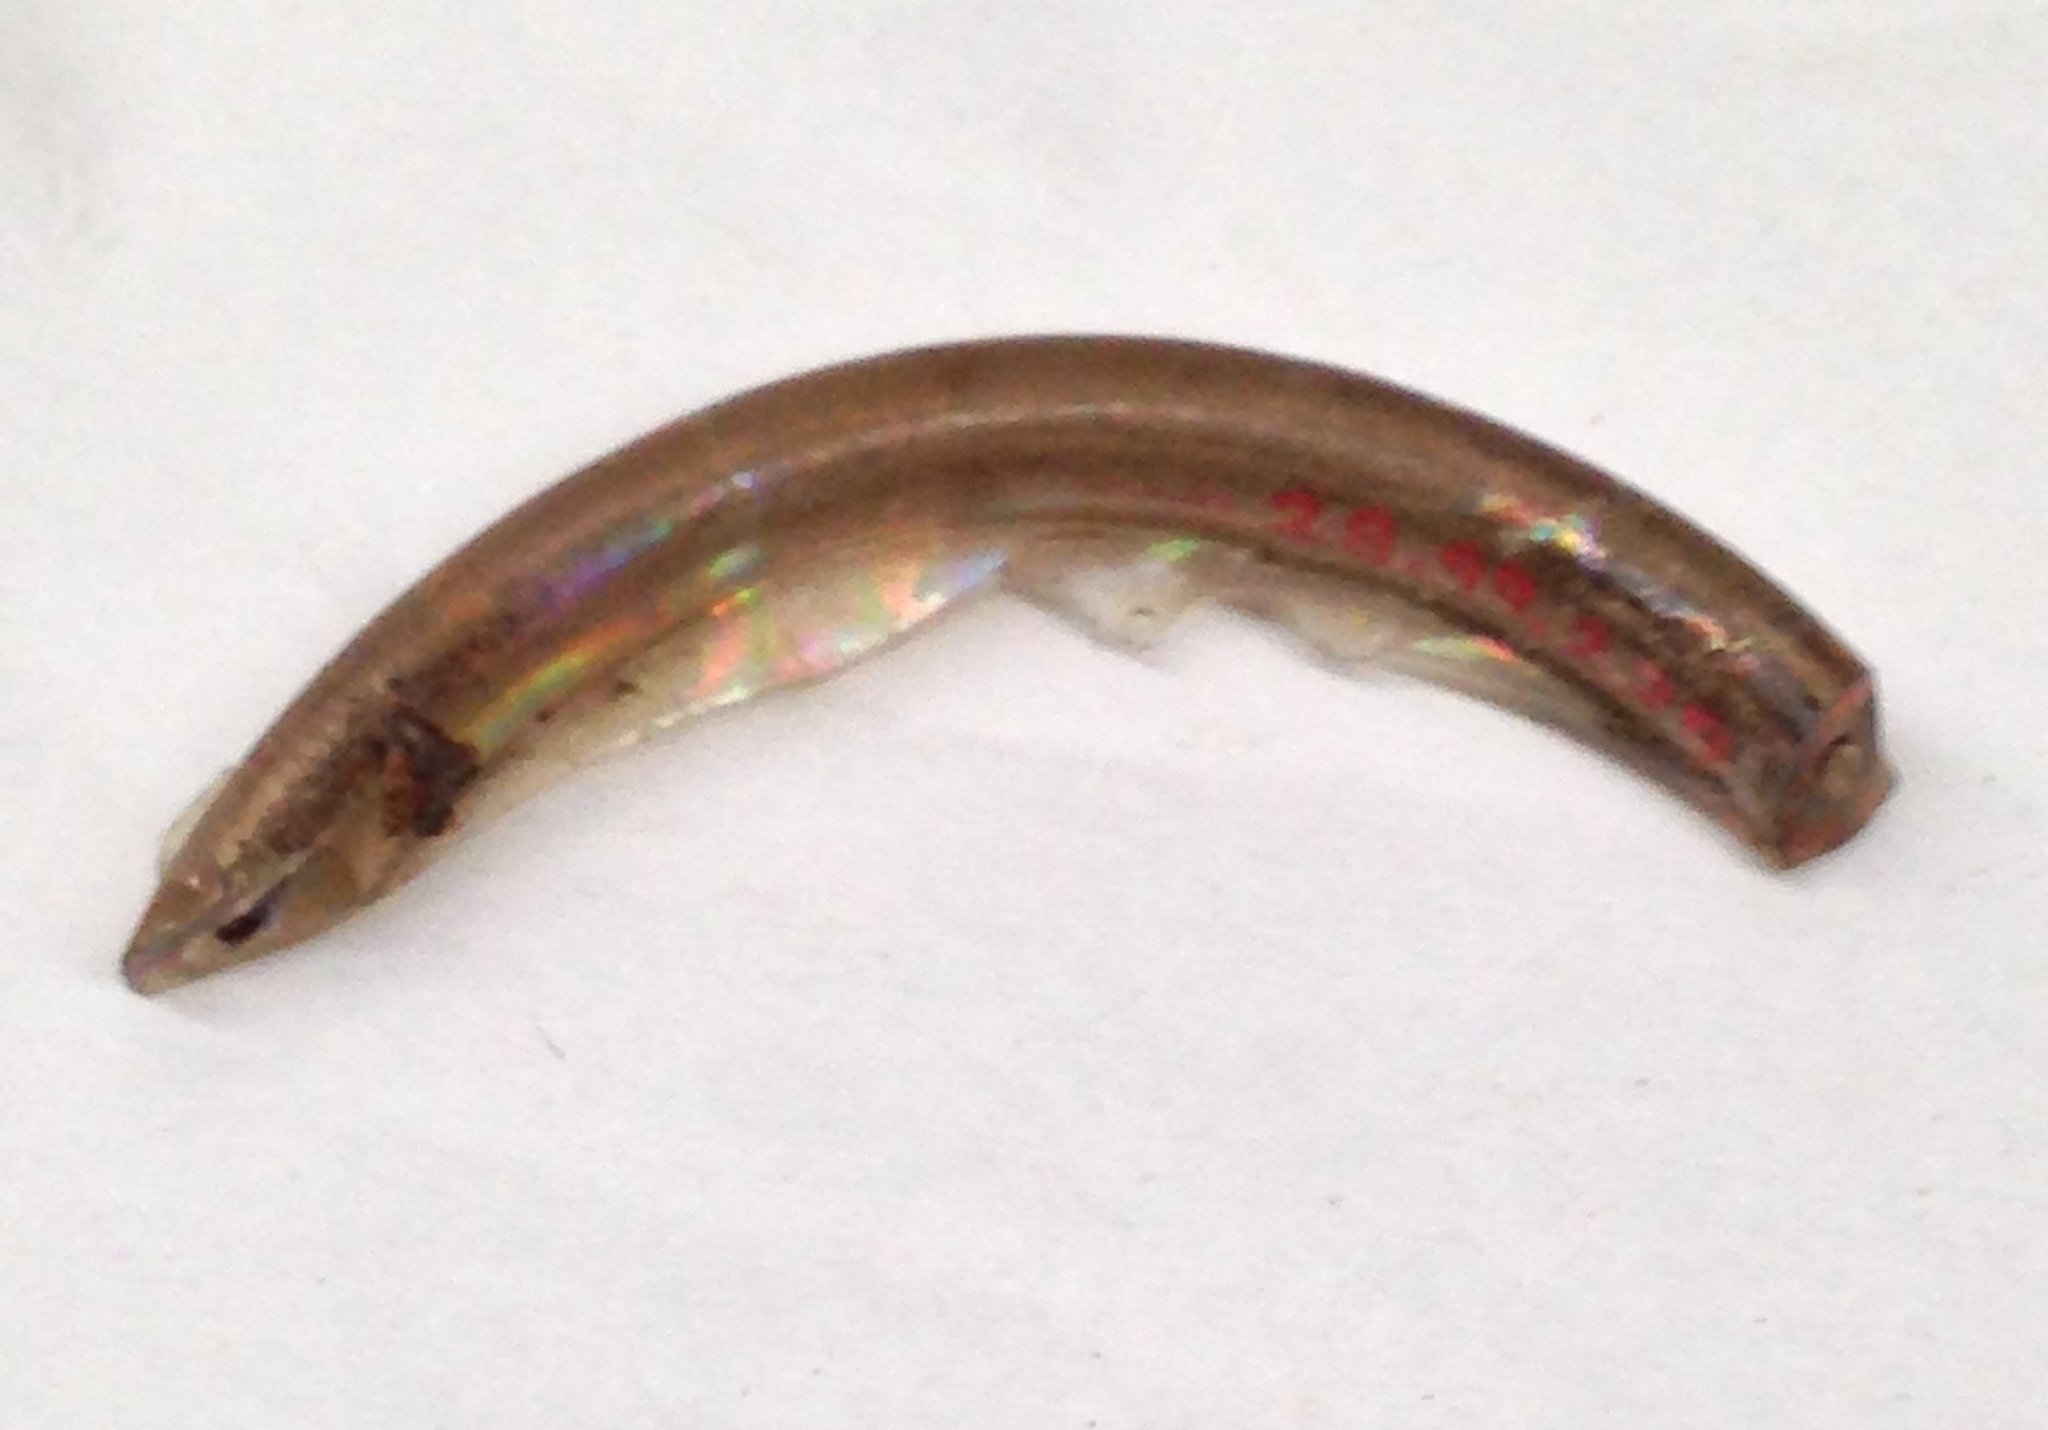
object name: fragment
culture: european or middle eastern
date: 1150-1250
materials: ceramic, glass